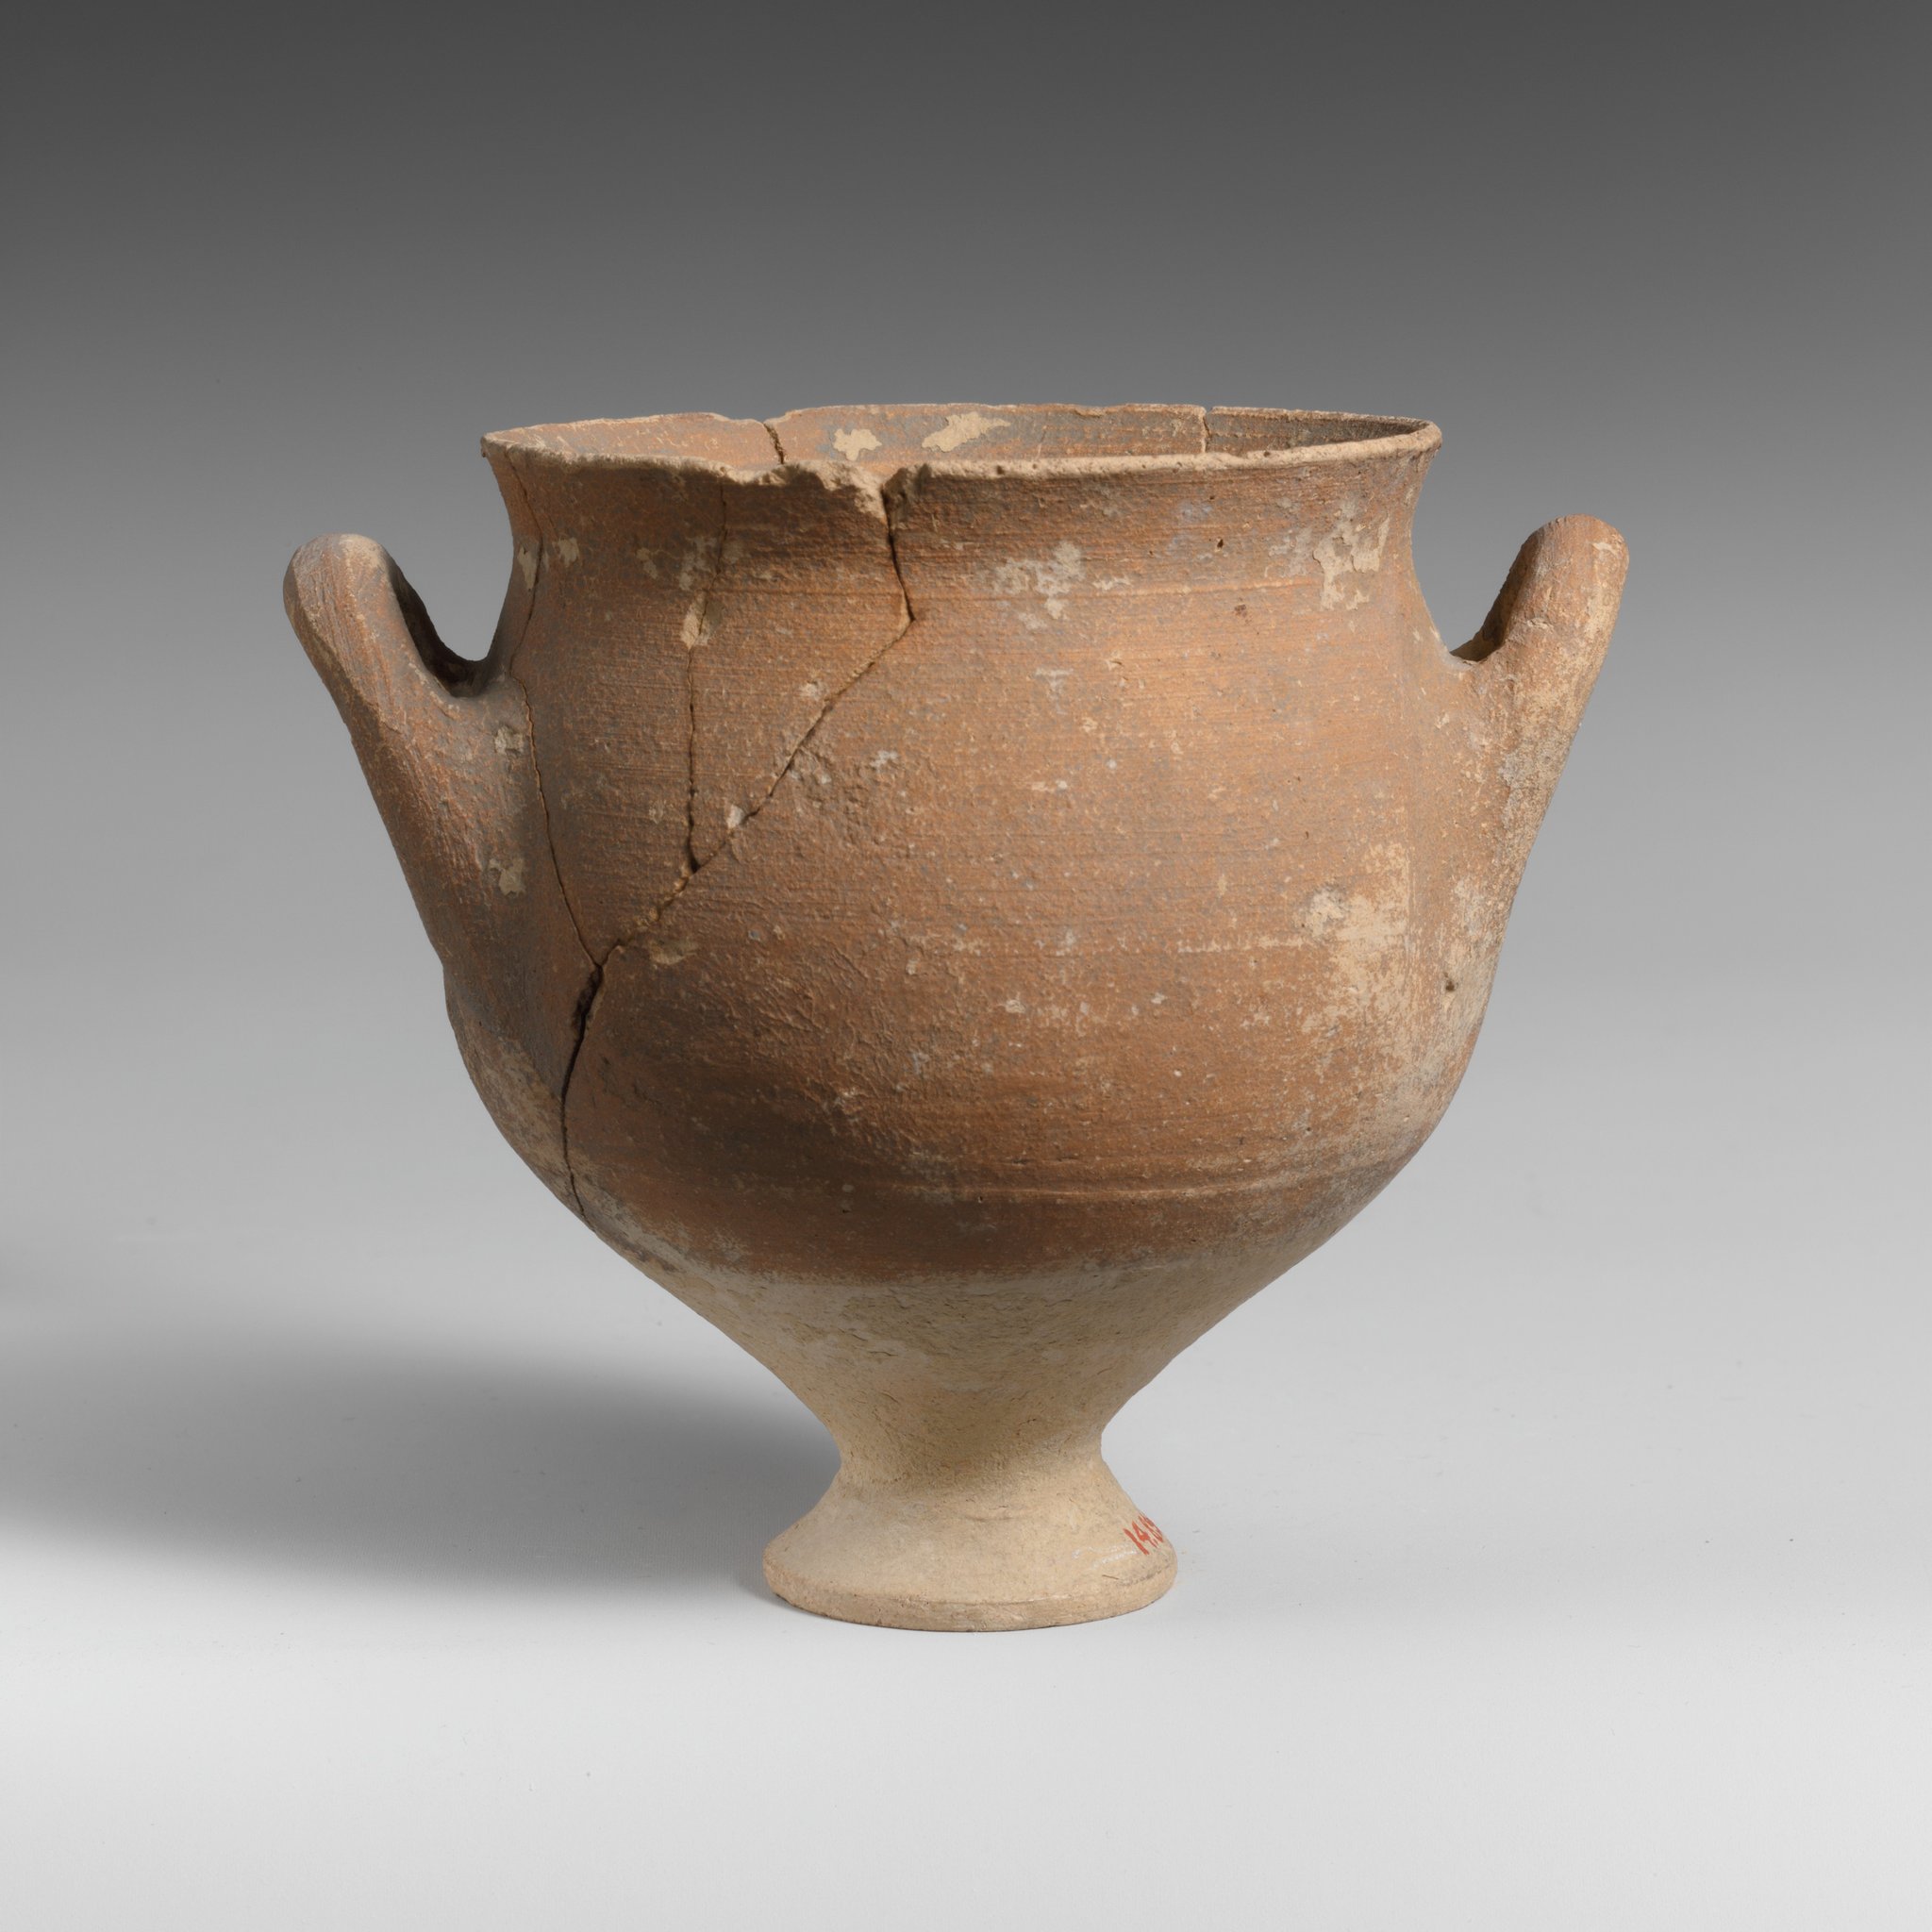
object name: jar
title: Terracotta deep skyphos (drinking cup)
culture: greek, cretan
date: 1100-801 BCE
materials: terracotta